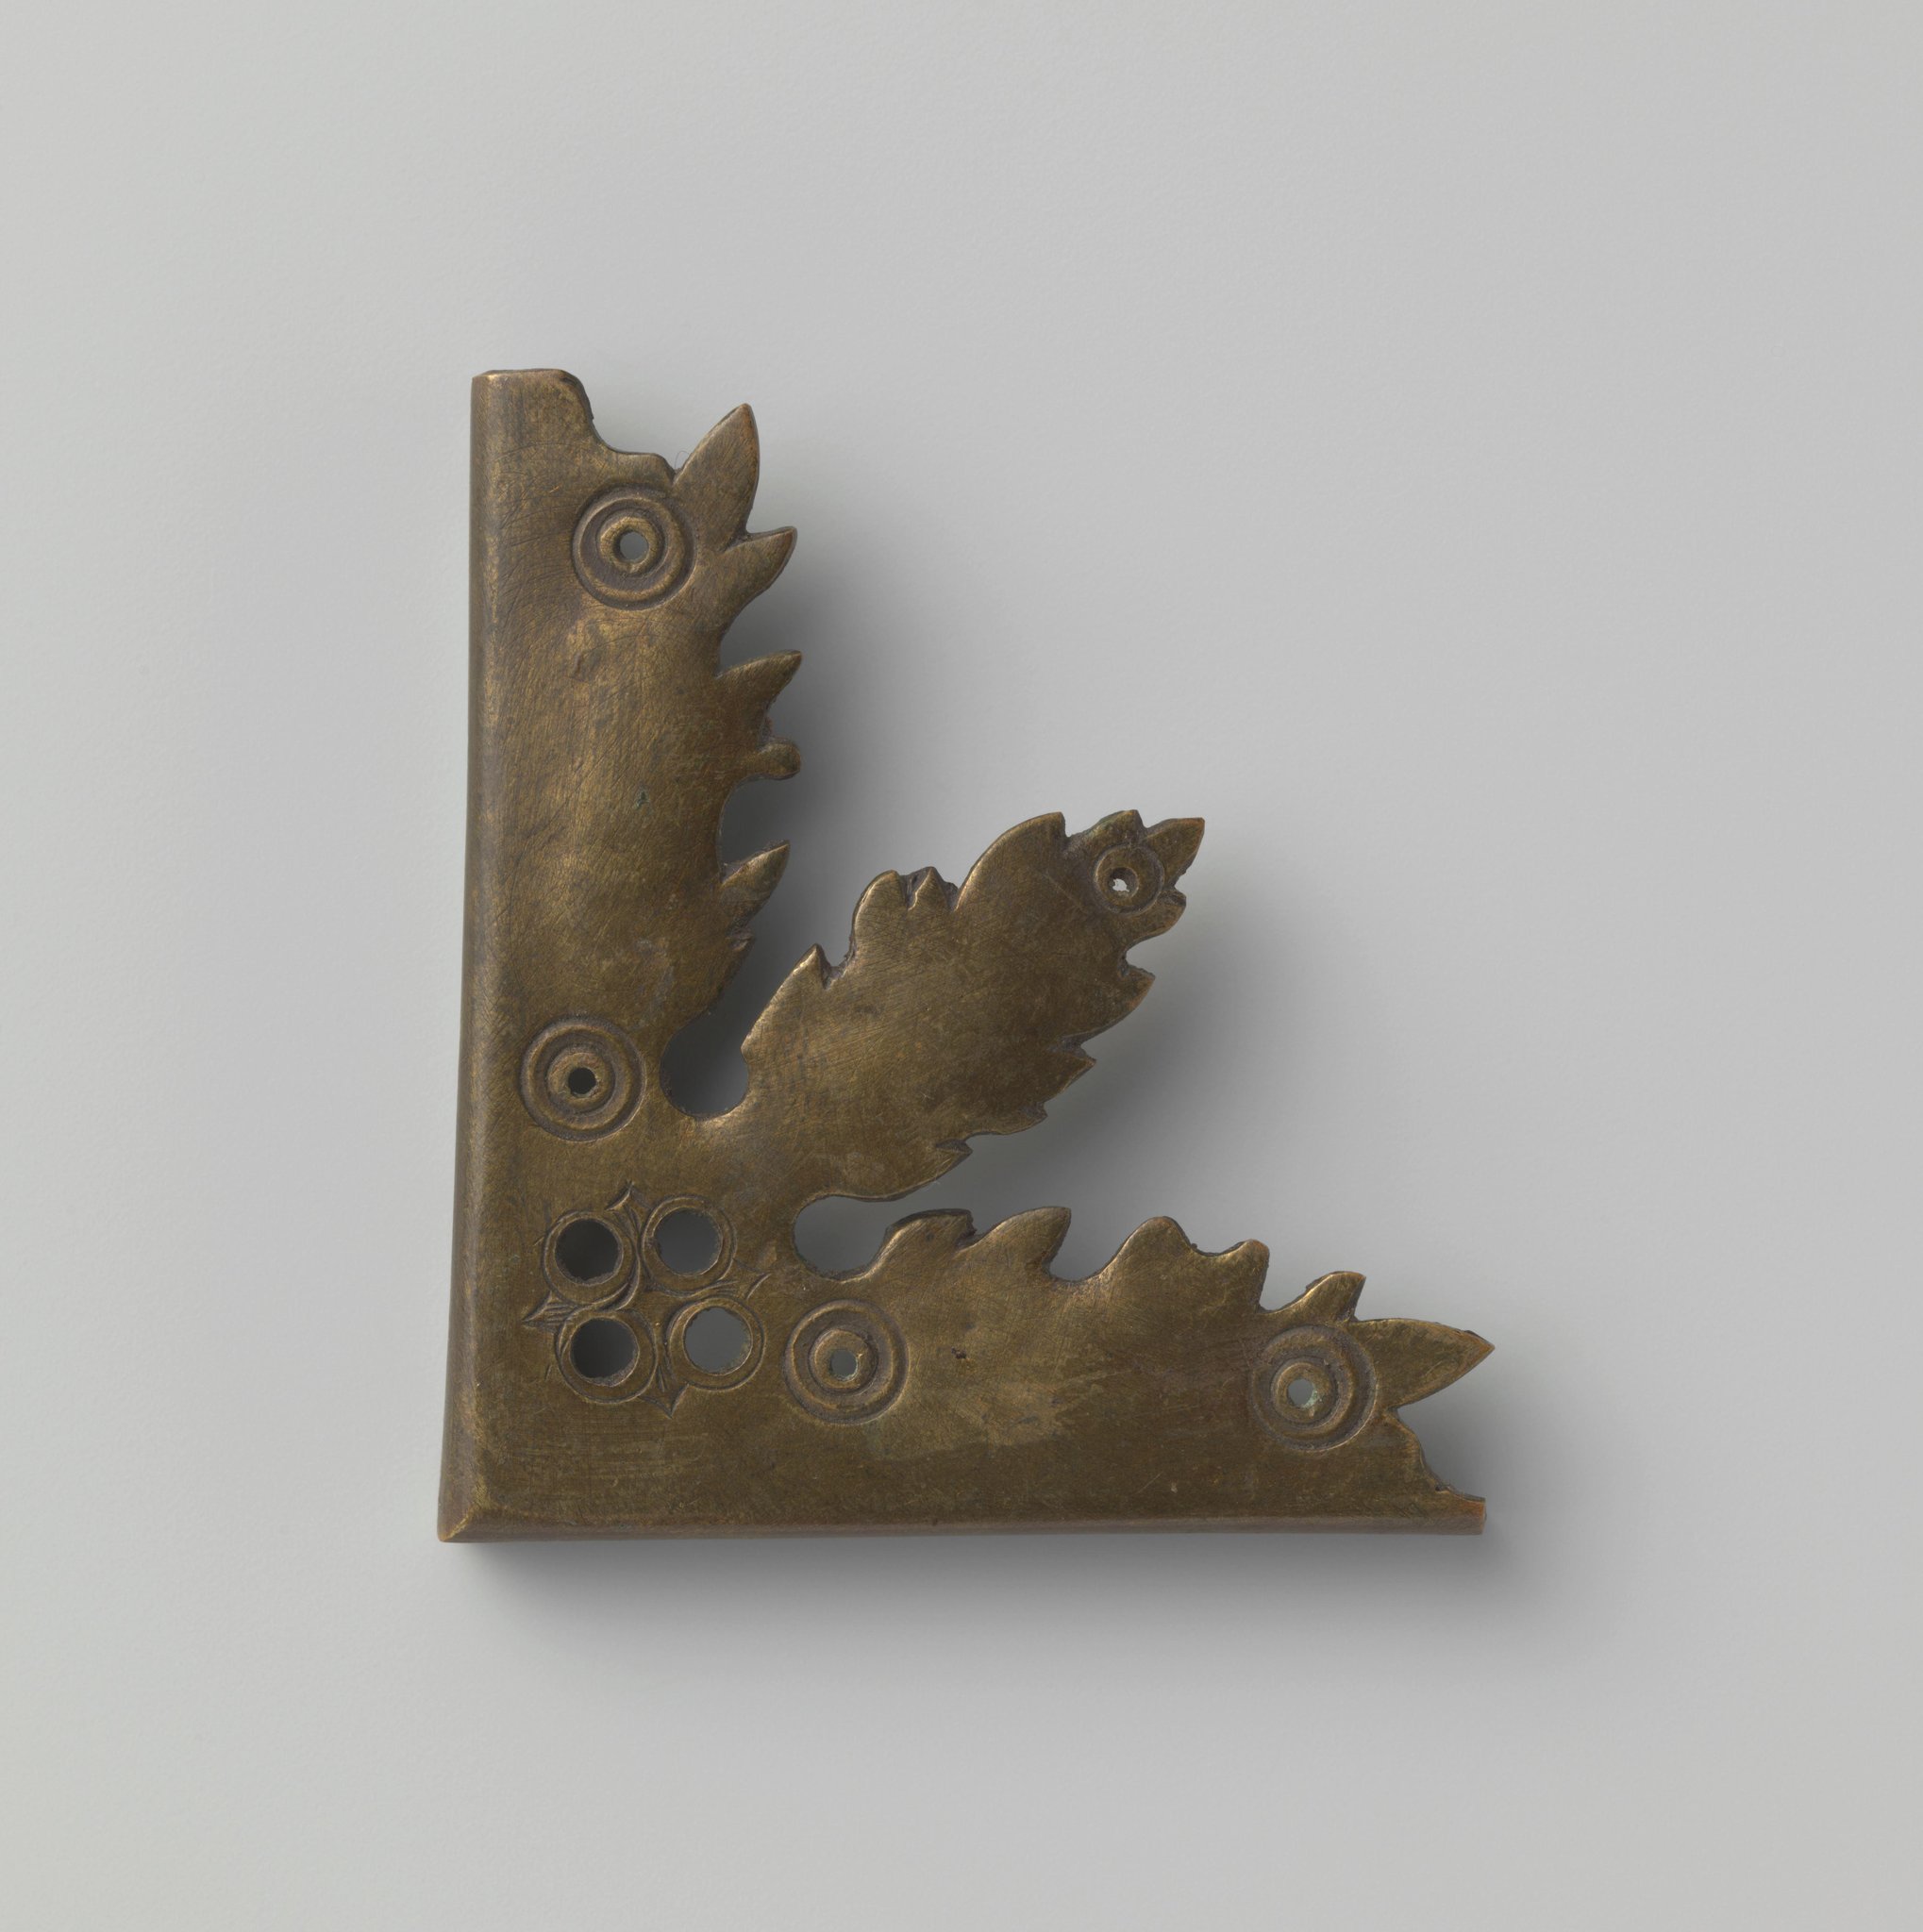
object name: binding finishing hardware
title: Hoekstuk van een boekbeslag (?)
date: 1400-1950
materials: brass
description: Hoekstuk van een boekbeslag (?) van messing.